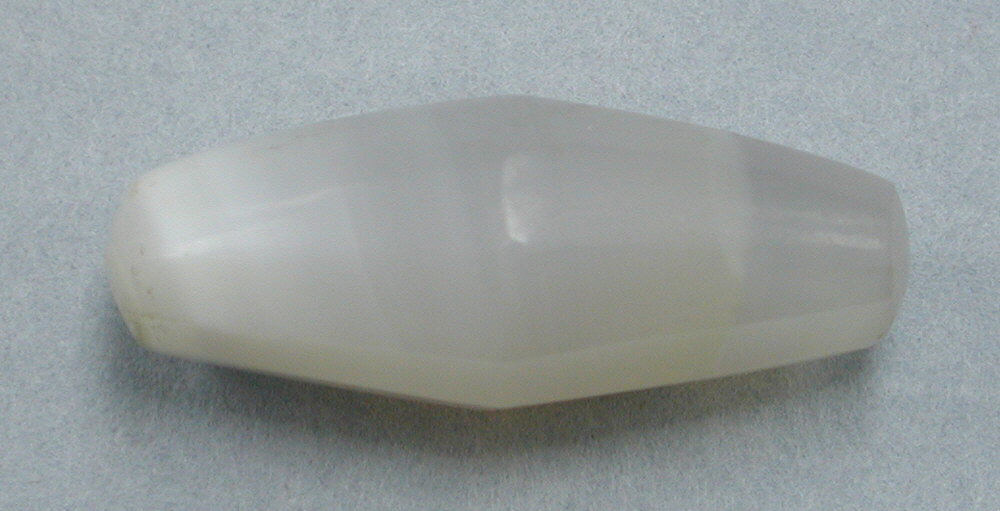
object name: ritual stone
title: Polishing Stone (pulidor)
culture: mexican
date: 1501-1600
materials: stone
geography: mexico